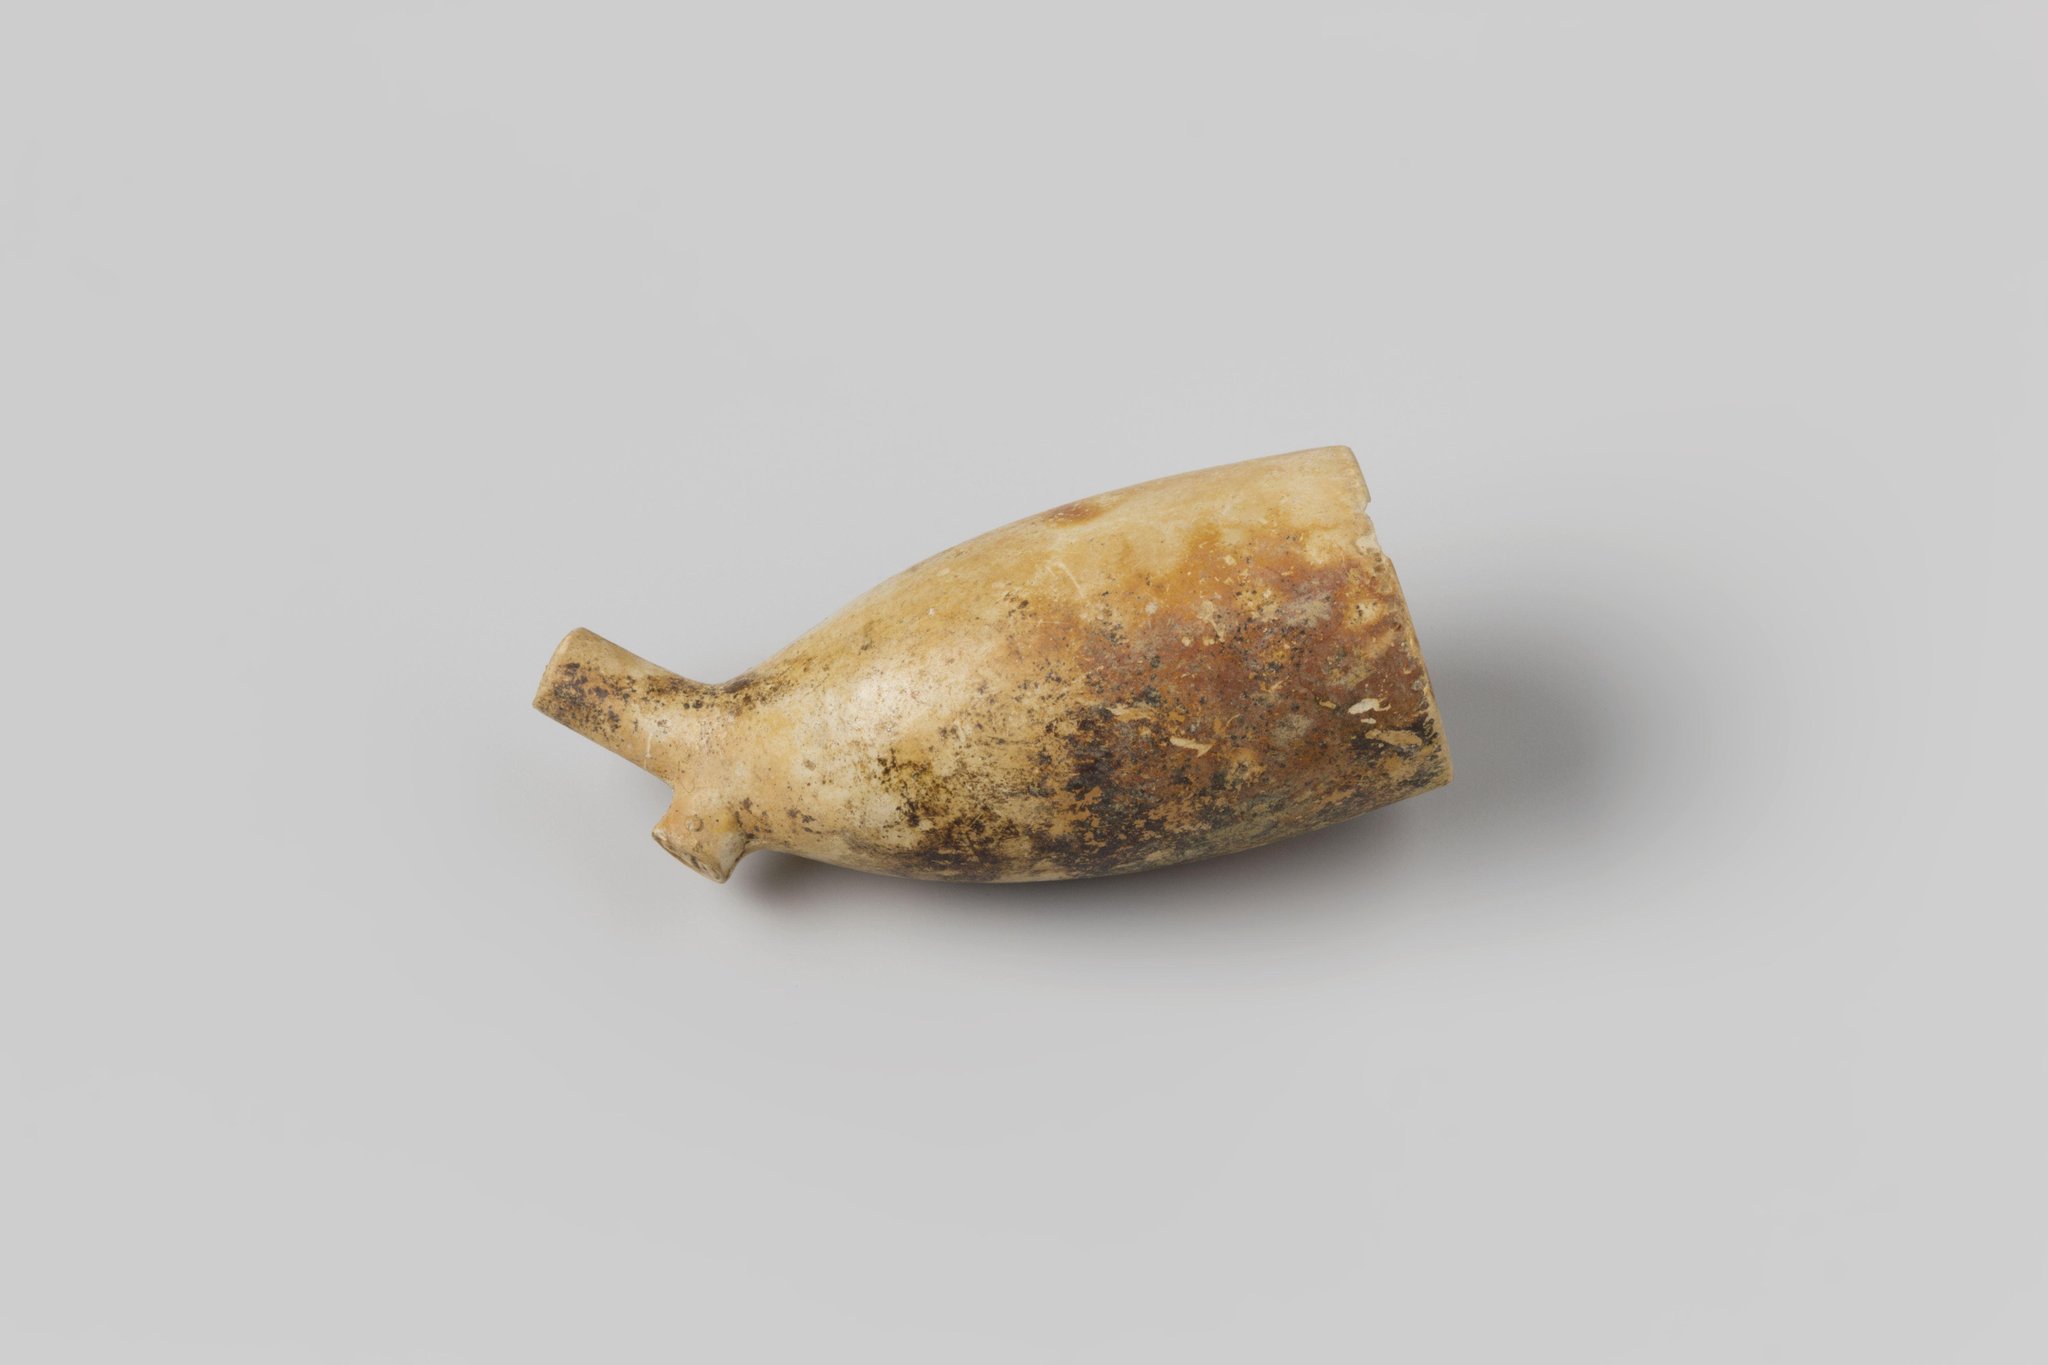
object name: pipe bowl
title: Fragment pijpenkop uit het wrak van de Oost-Indiëvaarder Hollandia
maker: Anonymous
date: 1700-1743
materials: clay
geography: netherlands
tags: verenigde oostindische compagnie, hollandia (schip), annet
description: Pipe, bowl, heelmark:crowned peat basket; fragment, 1hsm6.